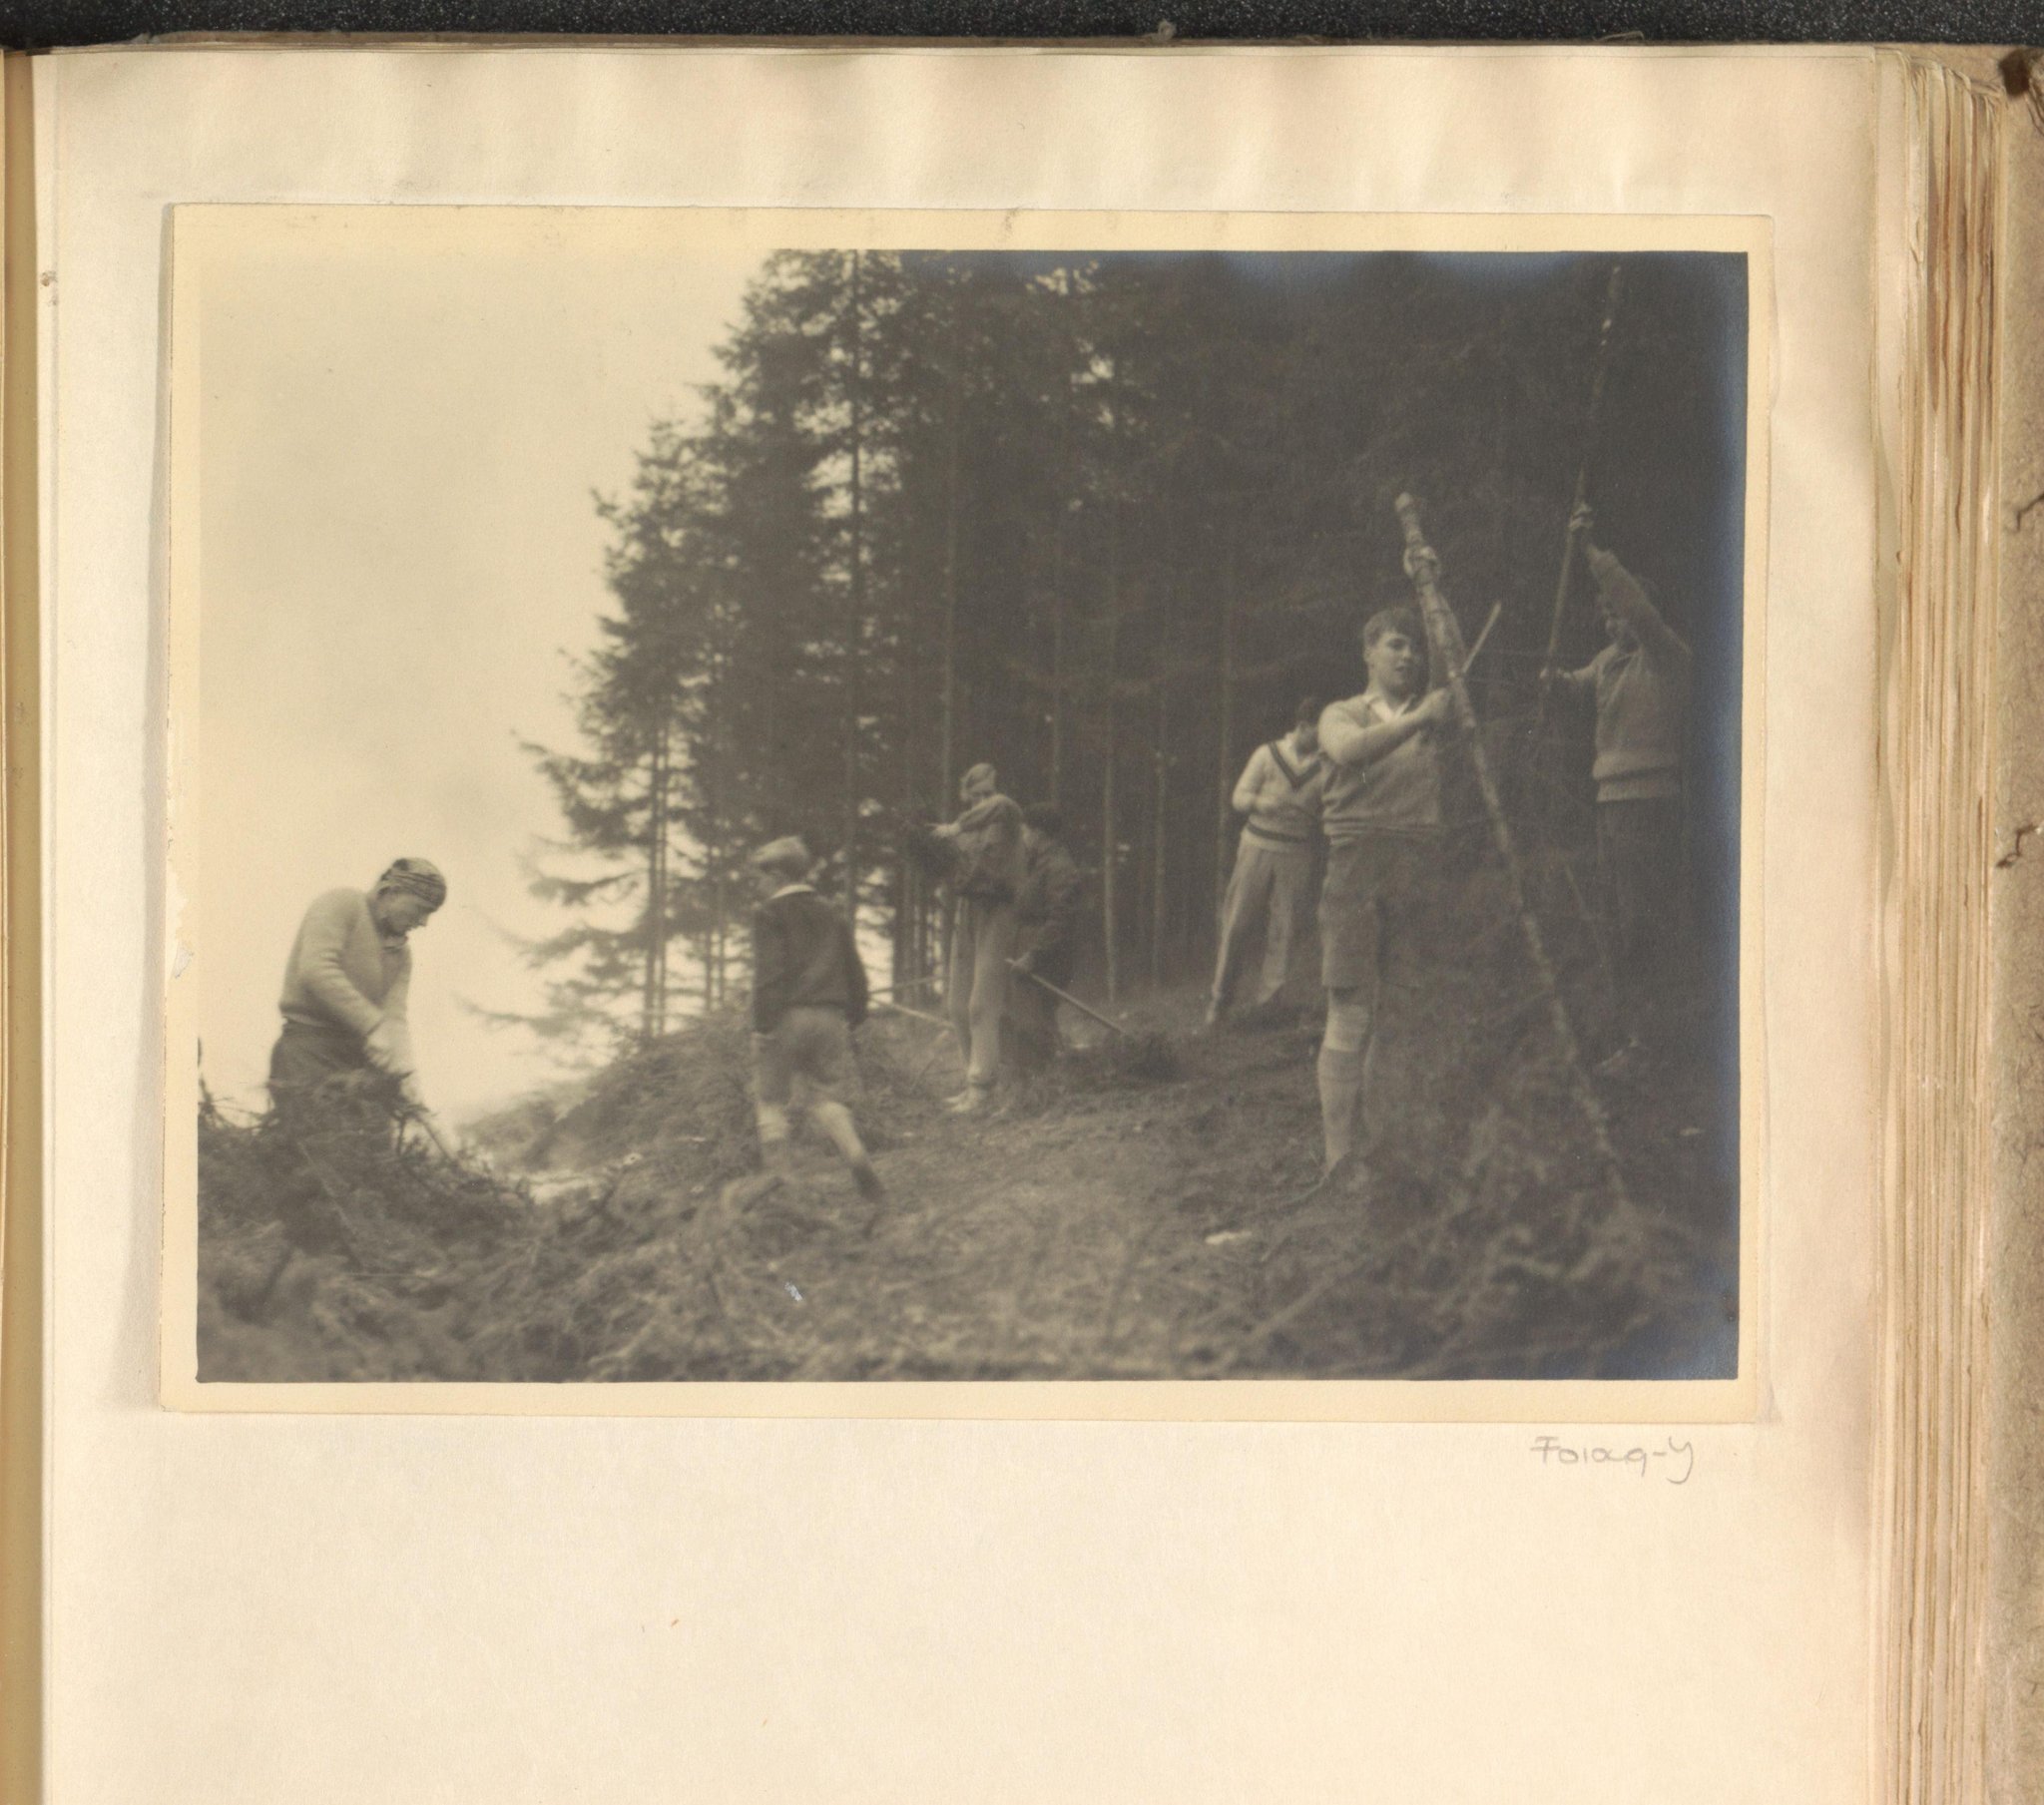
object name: photograph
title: Leerlingen van Schule Schloss Salem assisteren een houtvester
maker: Anonymous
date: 1929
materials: photographic support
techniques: gelatin silver print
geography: salem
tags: education, sawing (industrial process)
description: Onderdeel van Fotoalbum van Schule Schloss Salem.